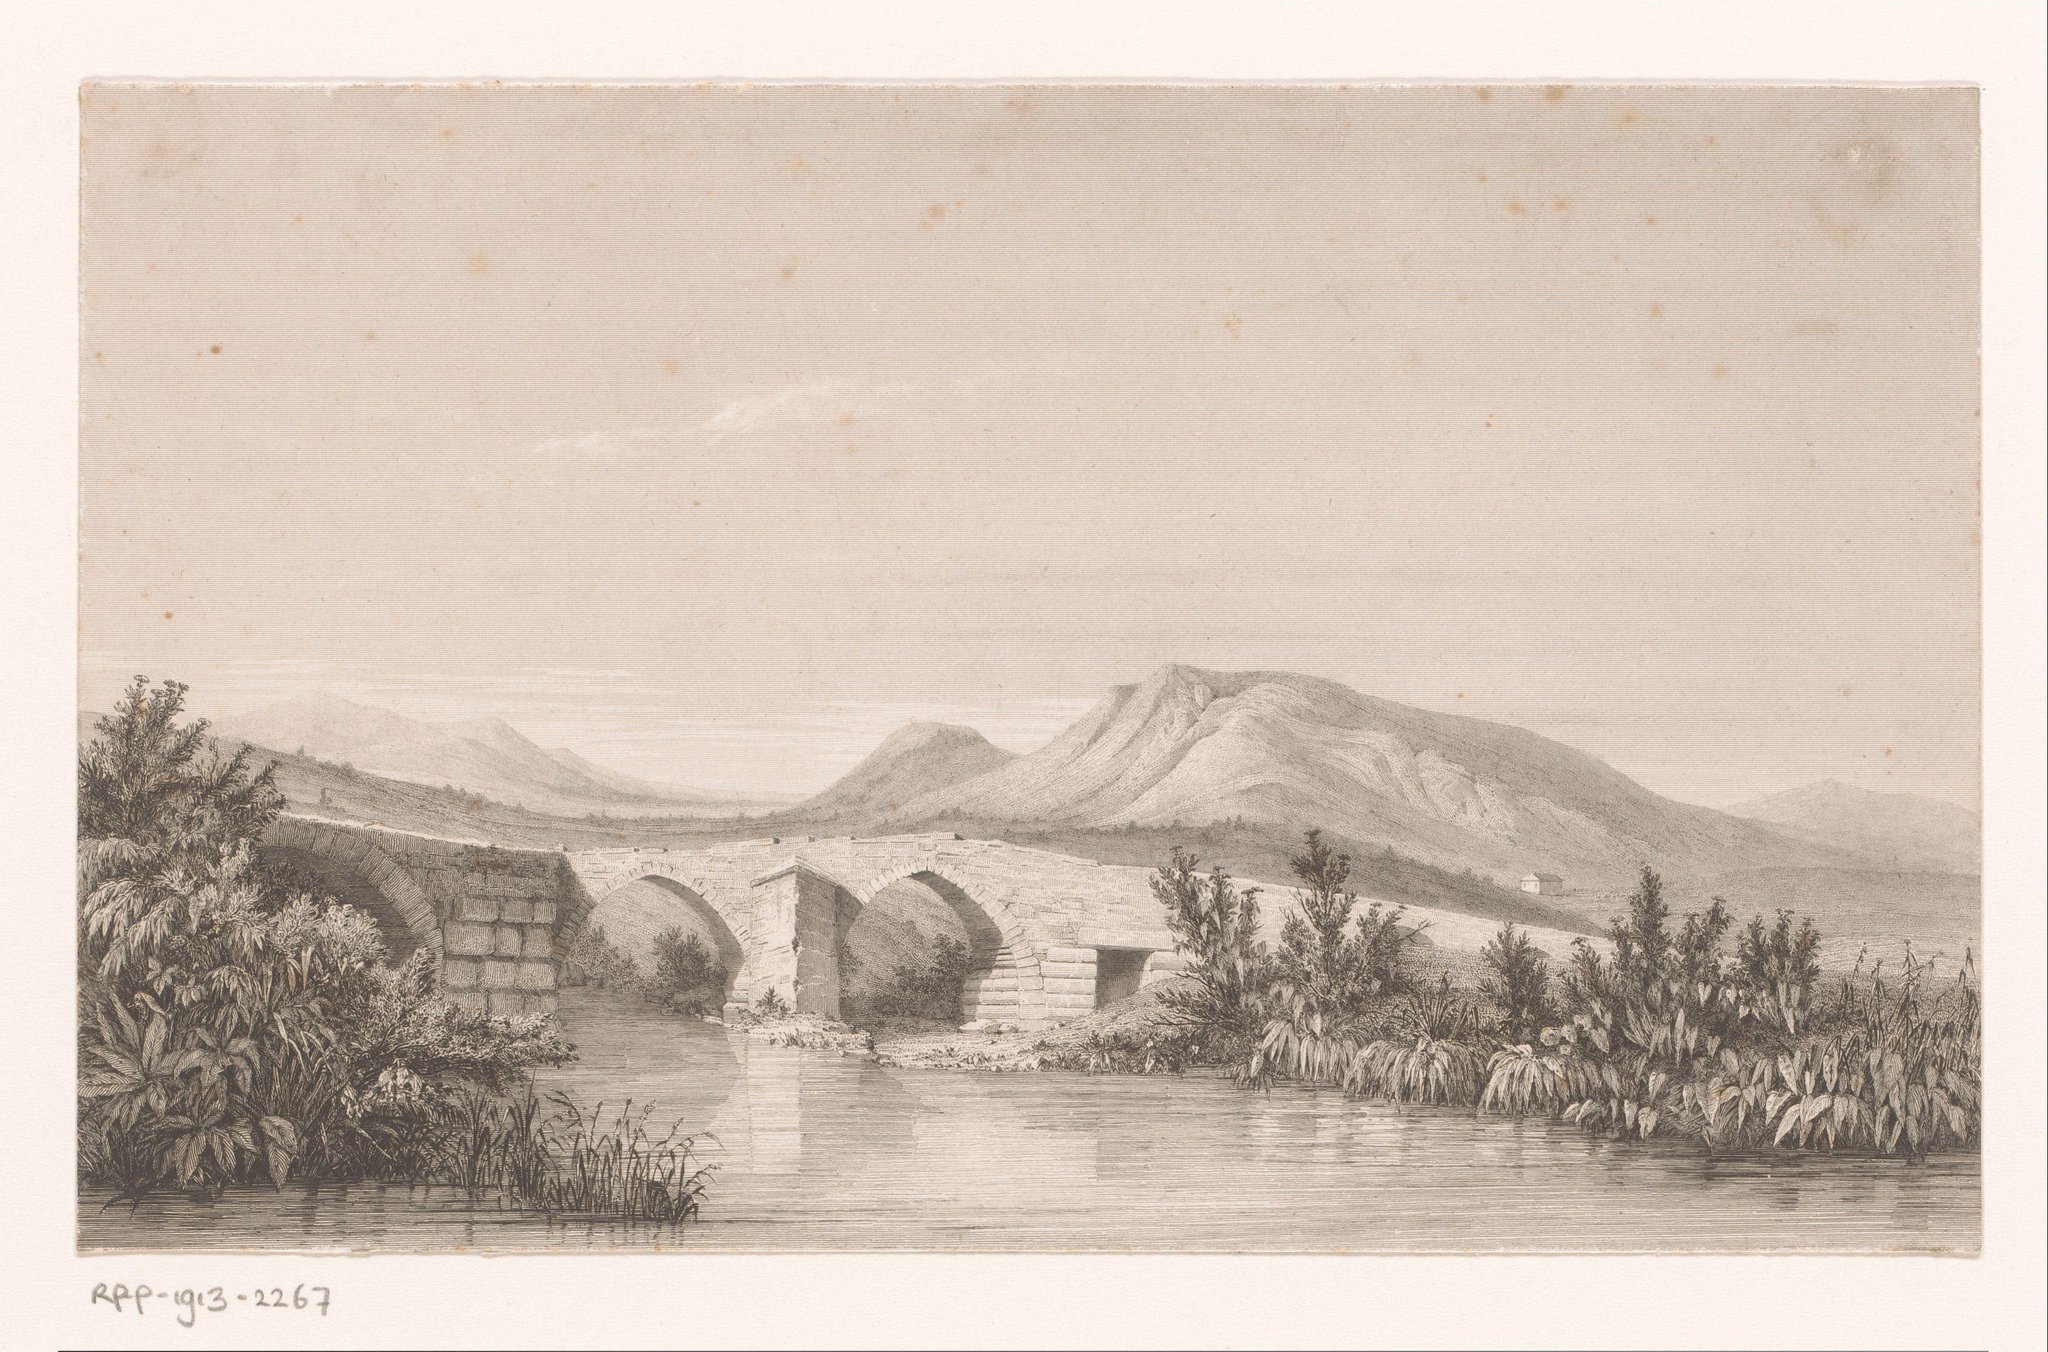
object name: print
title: Heuvellandschap met brug over het water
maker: auguste numans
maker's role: print maker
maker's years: 1823-1883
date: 1833-1880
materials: paper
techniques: etching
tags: landscape with bridge, viaduct or aqueduct, (high) hill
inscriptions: collector's mark: Lugt 2228